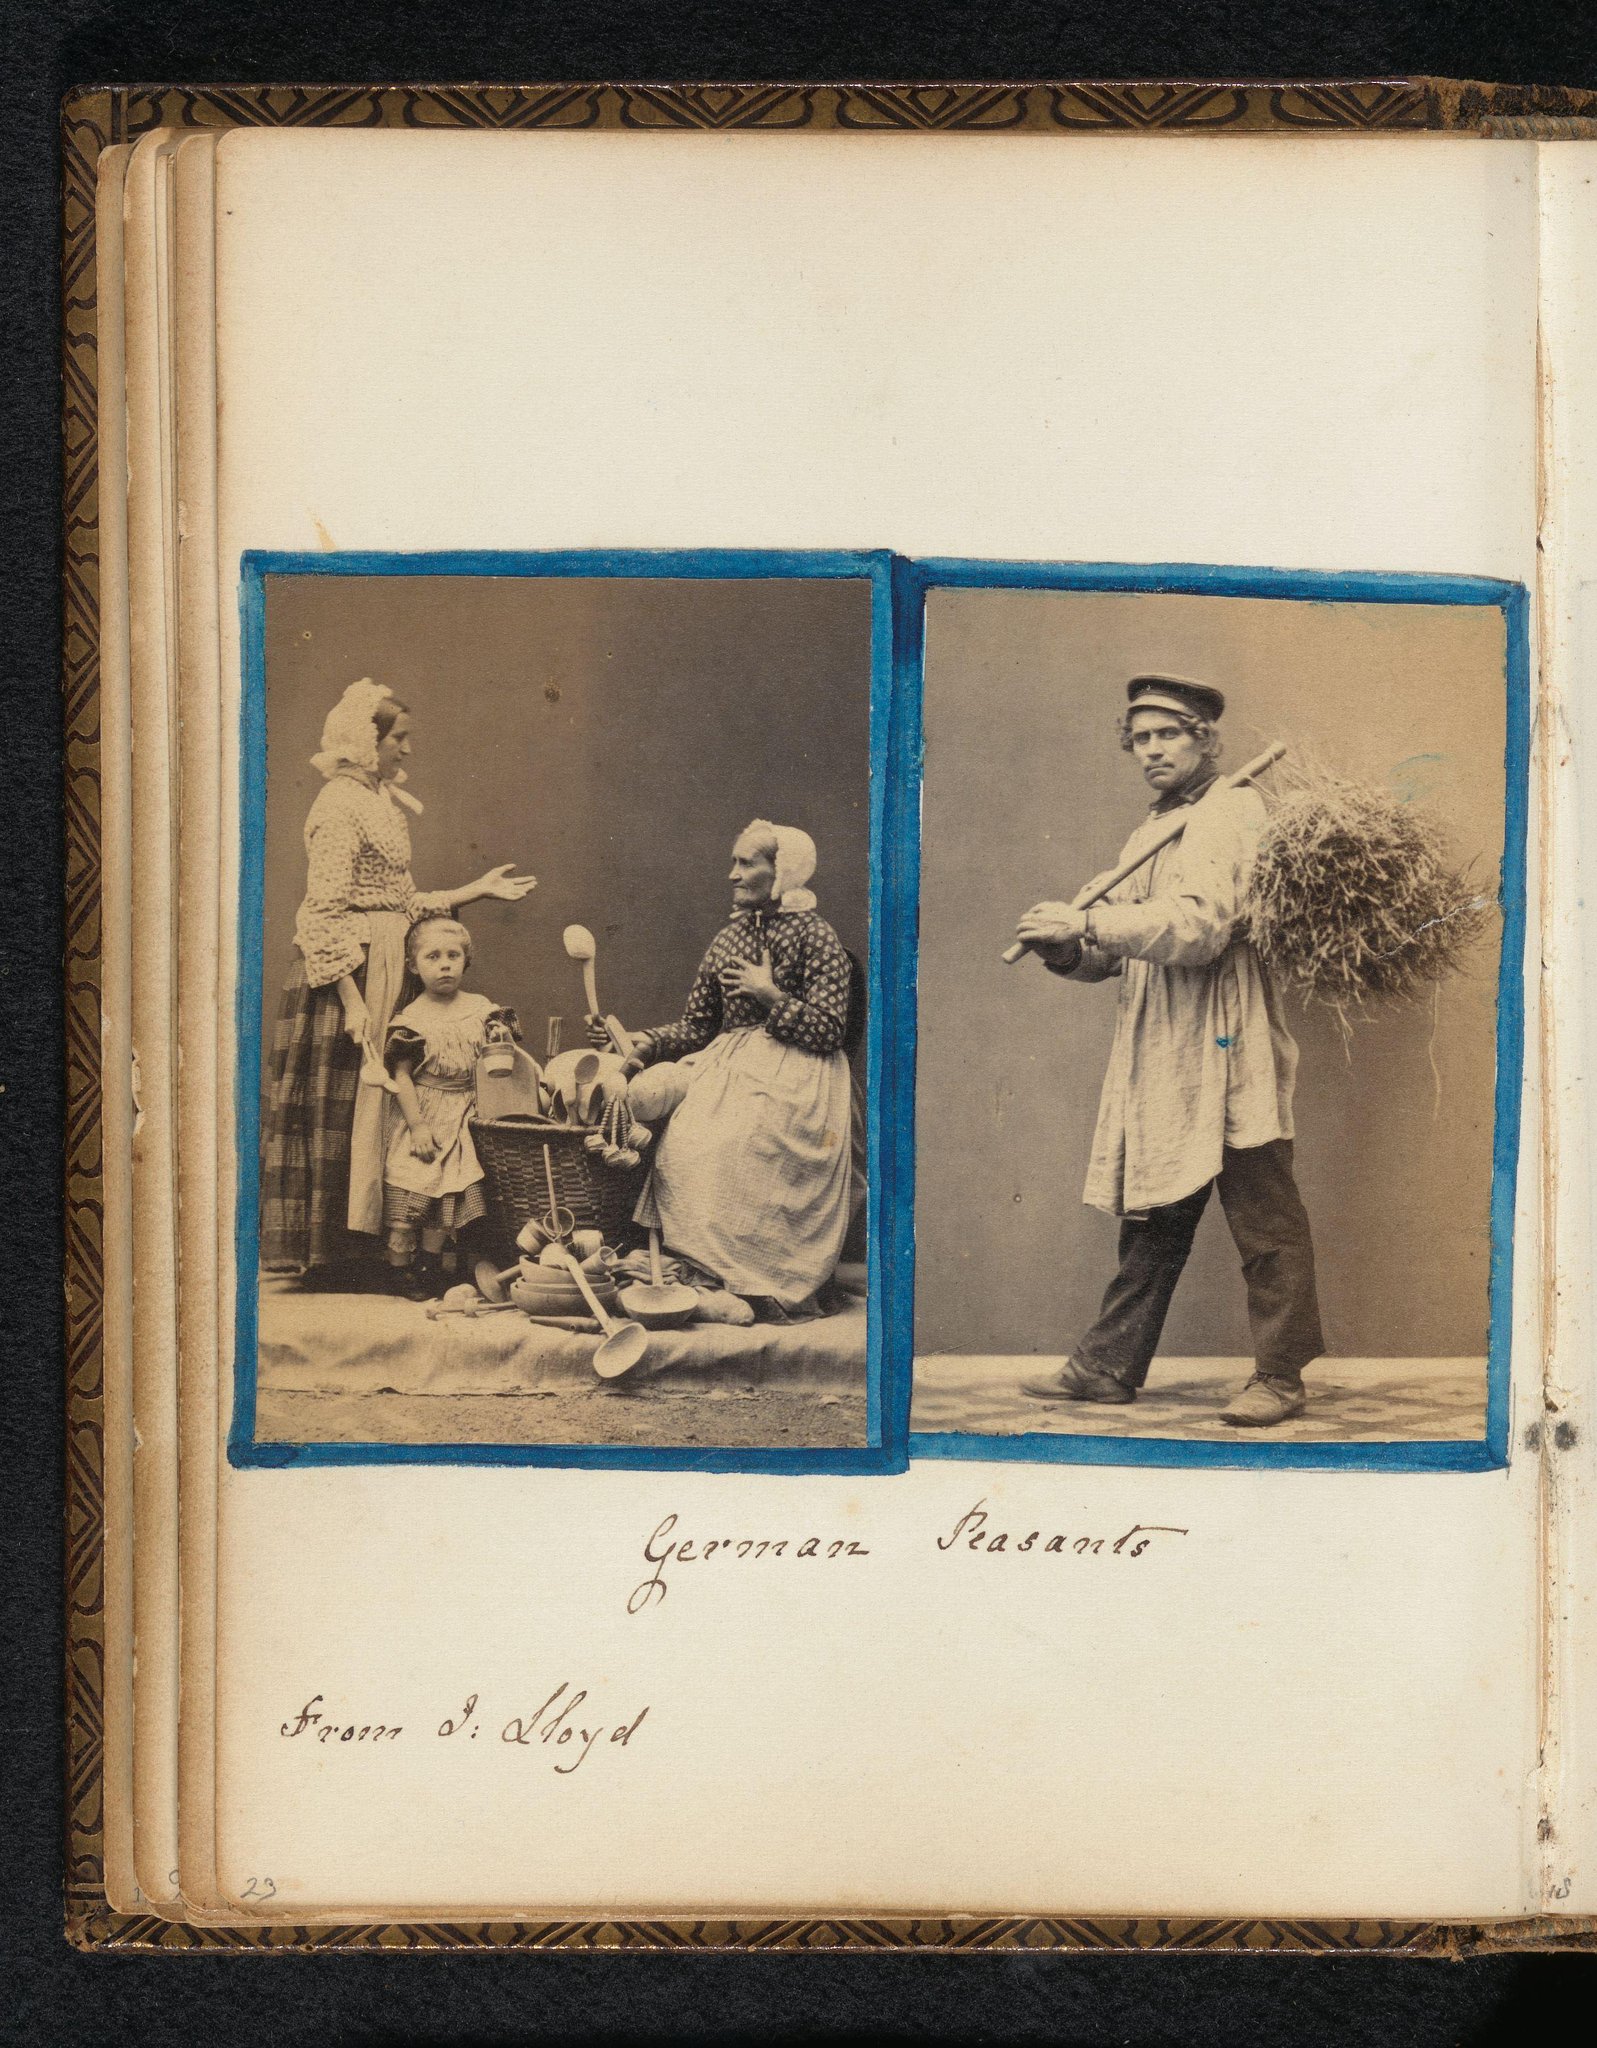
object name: photograph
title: German Peasants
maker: Anonymous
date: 1865-1867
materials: cardboard, photographic support, watercolor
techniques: albumen print, aquarelle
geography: england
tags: farmers, germany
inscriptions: annotation: ‘German Peasants / from J: Lloyd’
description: Twee foto's van Duitse boeren. Foto's op albumblad in album met 68 foto's merendeels met geaquarelleerde randversieringen. Het zijn voornamelijk portretten op carte-de-visite formaat.